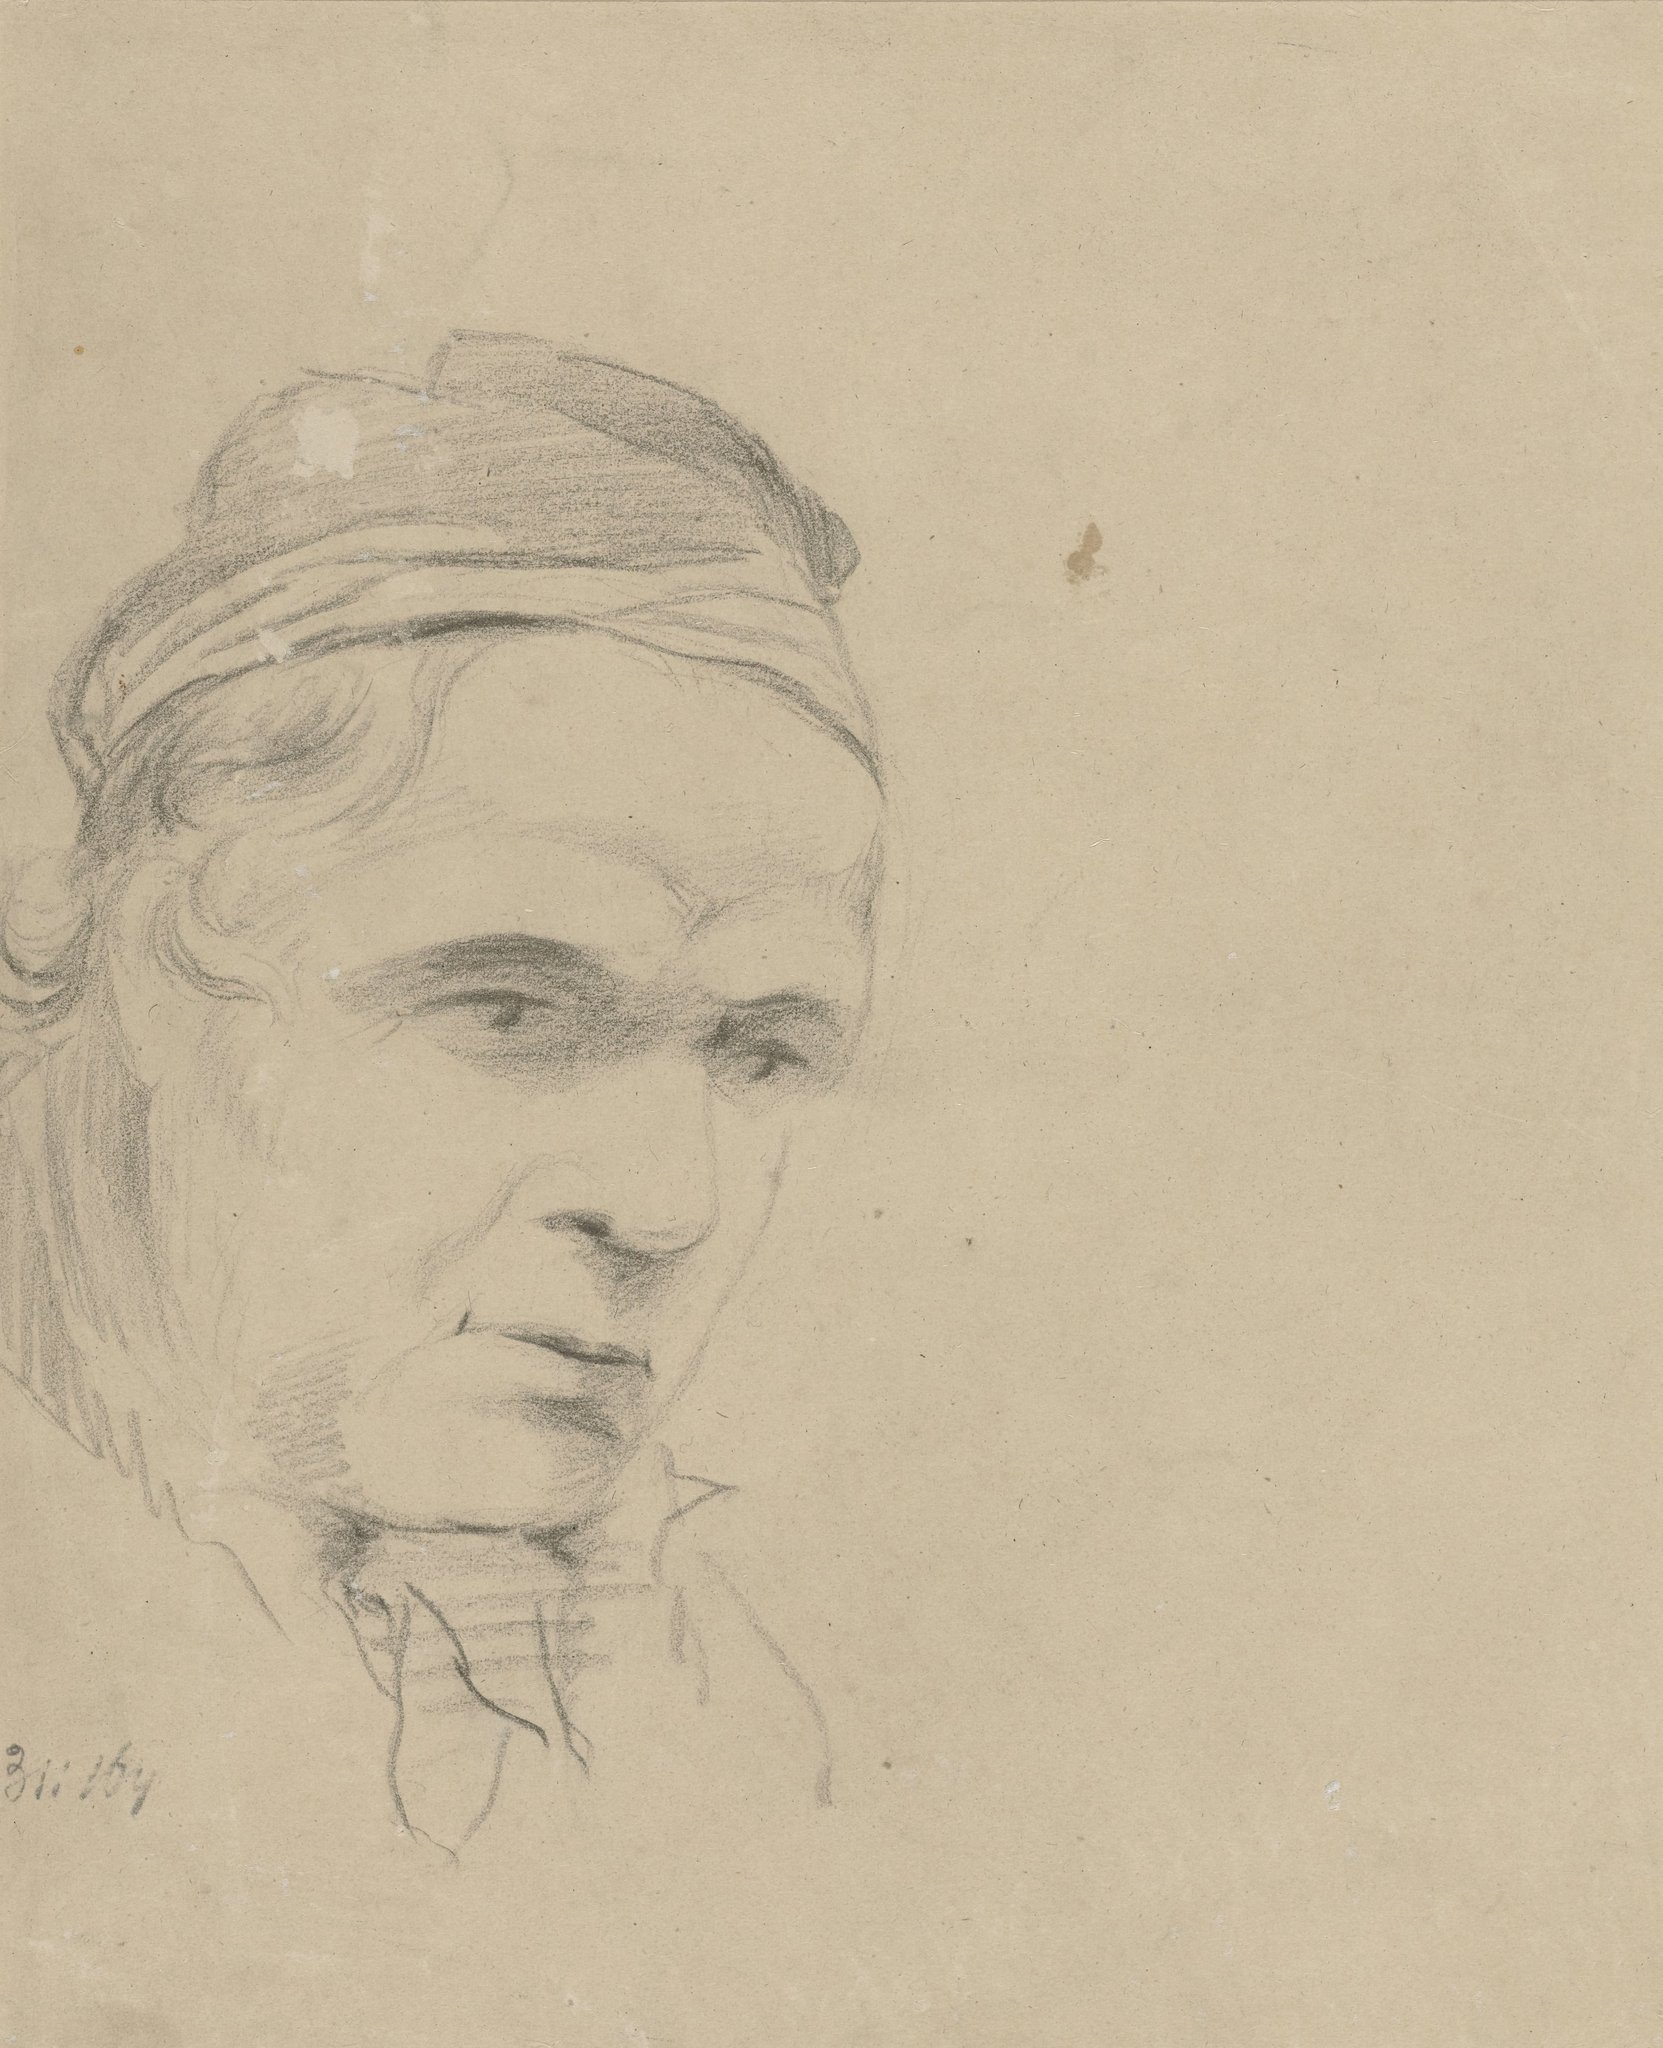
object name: drawing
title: Manskop, neerziend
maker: alexander cranendoncq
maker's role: draughtsman, print maker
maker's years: 1799-1869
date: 1809-1869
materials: chalk, paper